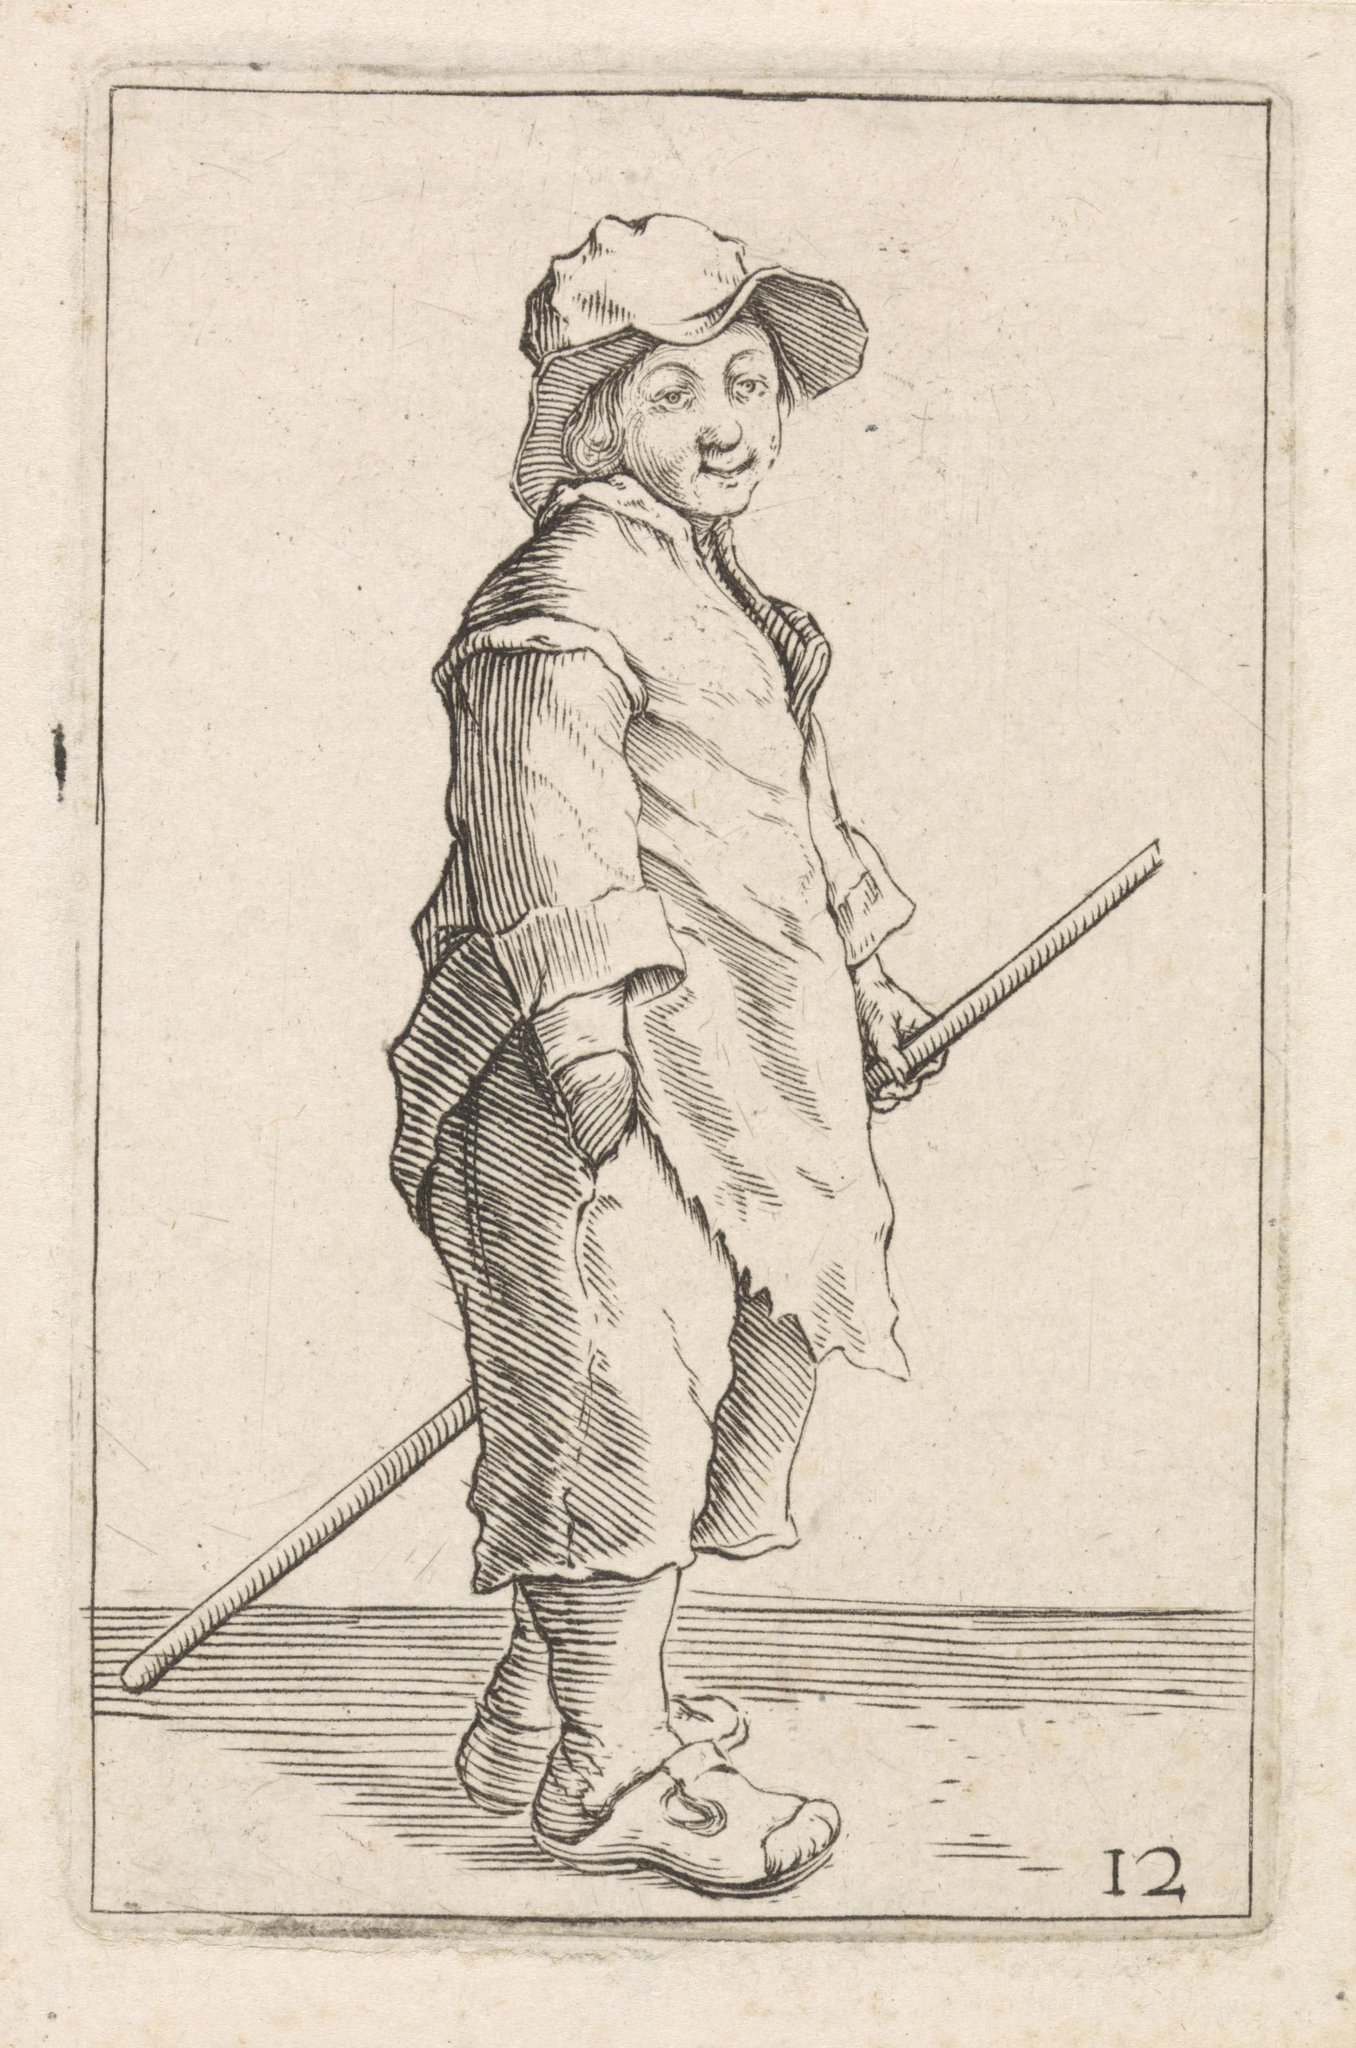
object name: print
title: Boeren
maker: cornelis saftleven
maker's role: draughtsman, painter, print maker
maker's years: 1607-1681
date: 1645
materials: paper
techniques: etching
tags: head-gear, walking-stick, staff, farmers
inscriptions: collector's mark: Lugt 240